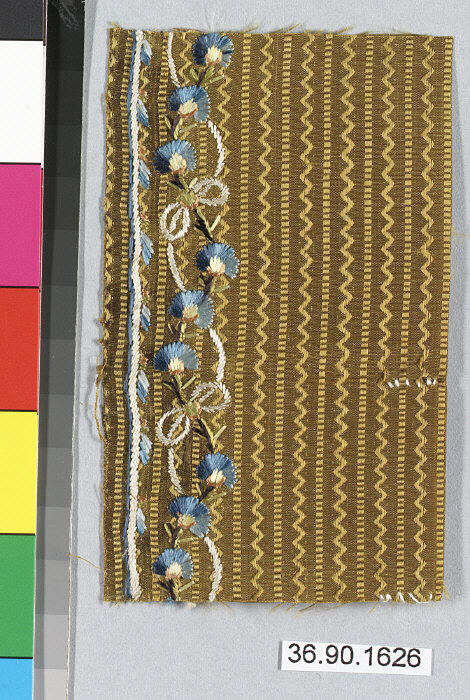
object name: sample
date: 1801-1833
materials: silk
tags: flowers